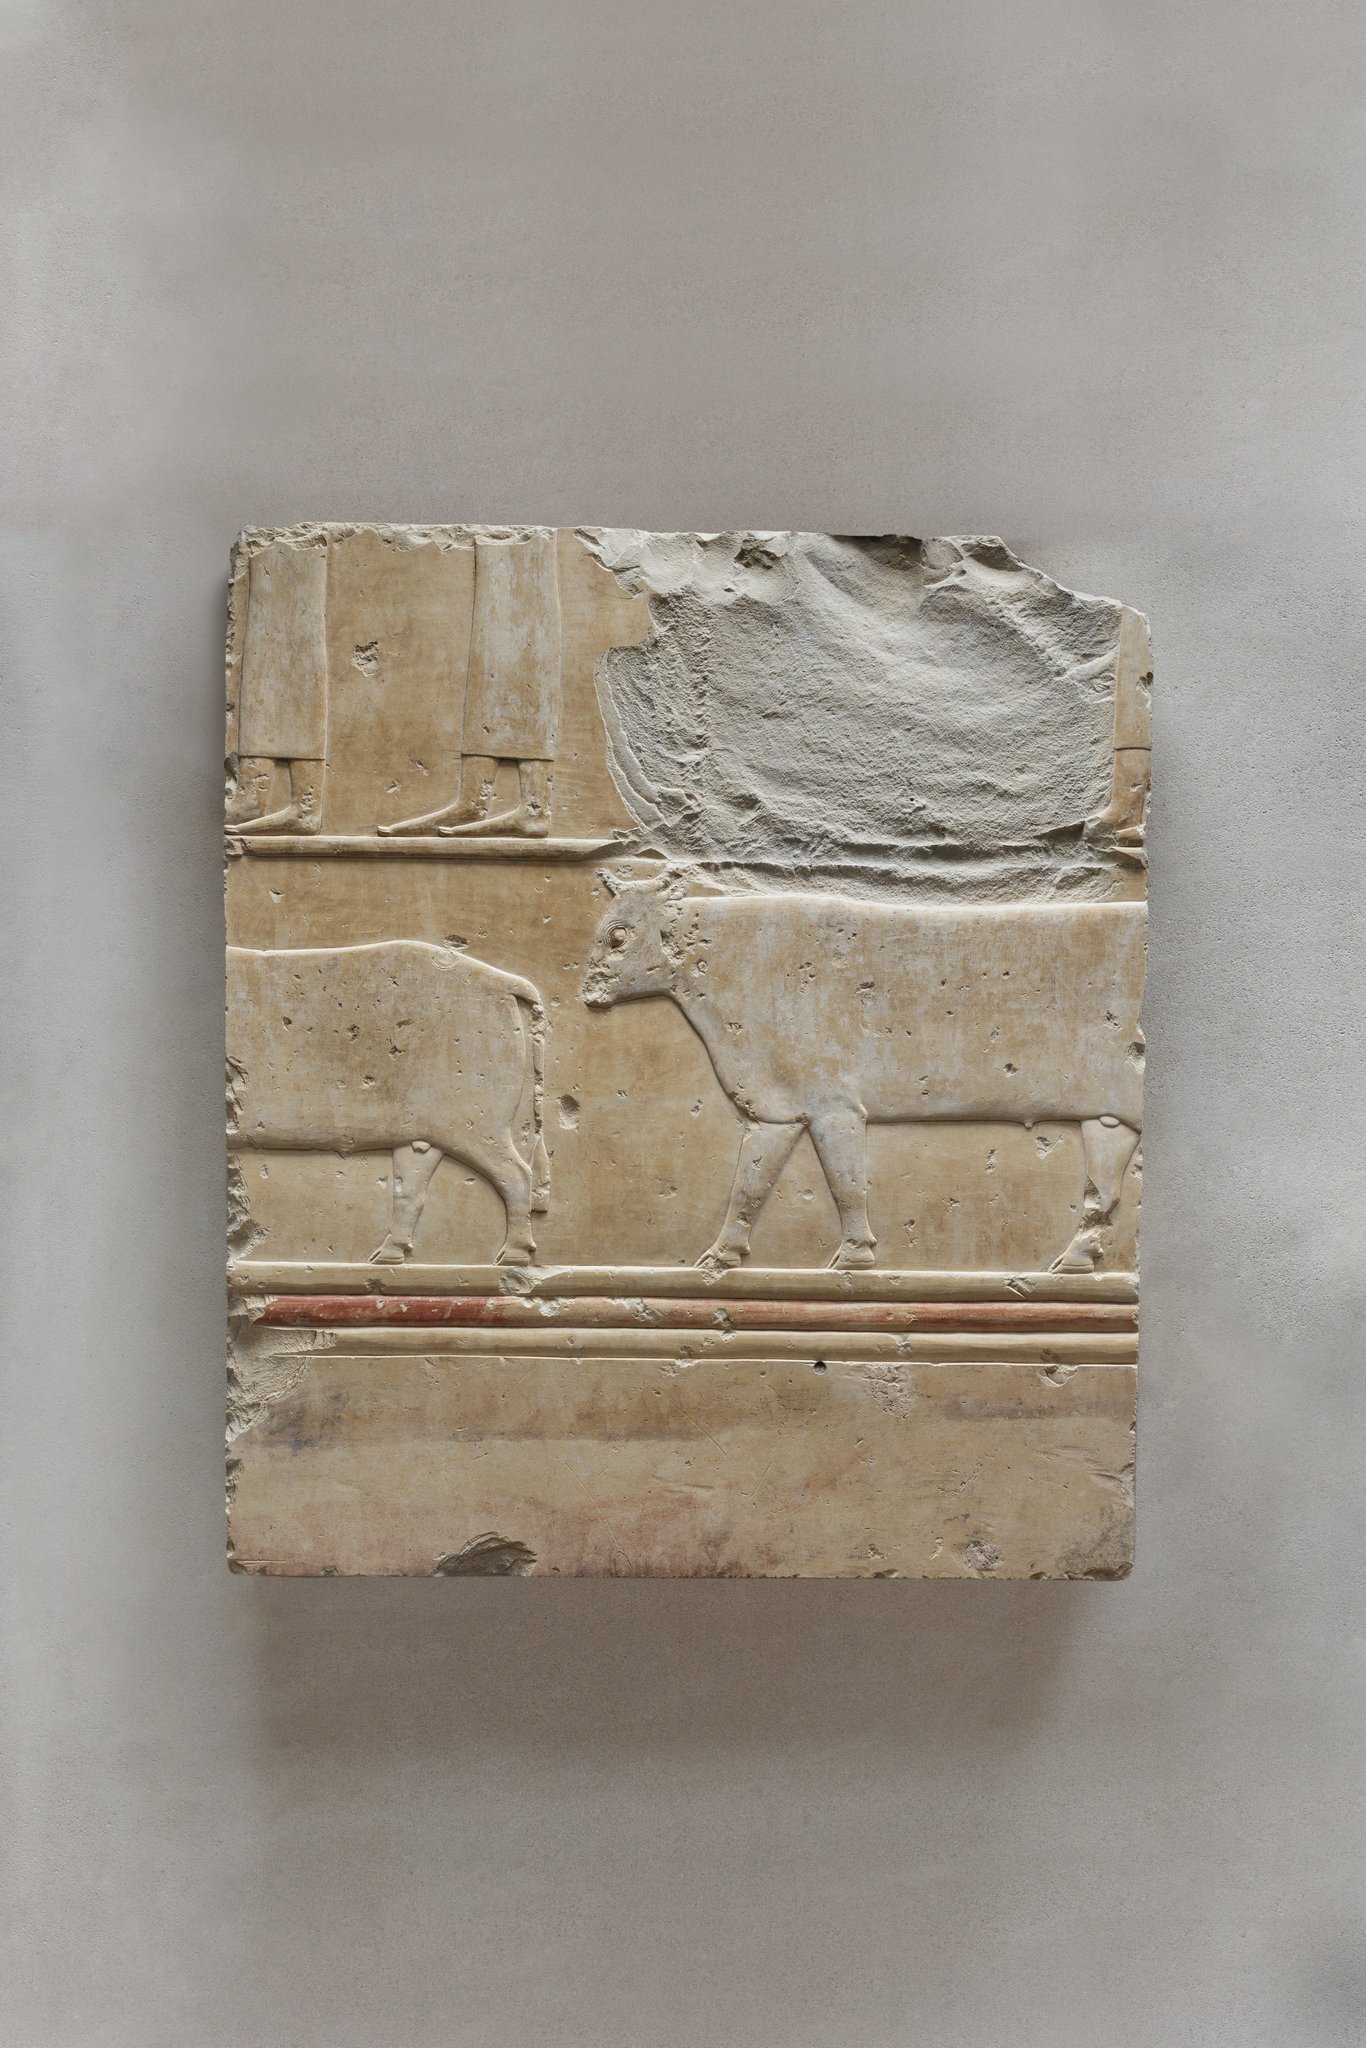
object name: relief, female attendant, neferu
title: Relief of female attendants and oxen - see 26.3.353-3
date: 2051-2030 BCE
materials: limestone, paint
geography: egypt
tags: ox